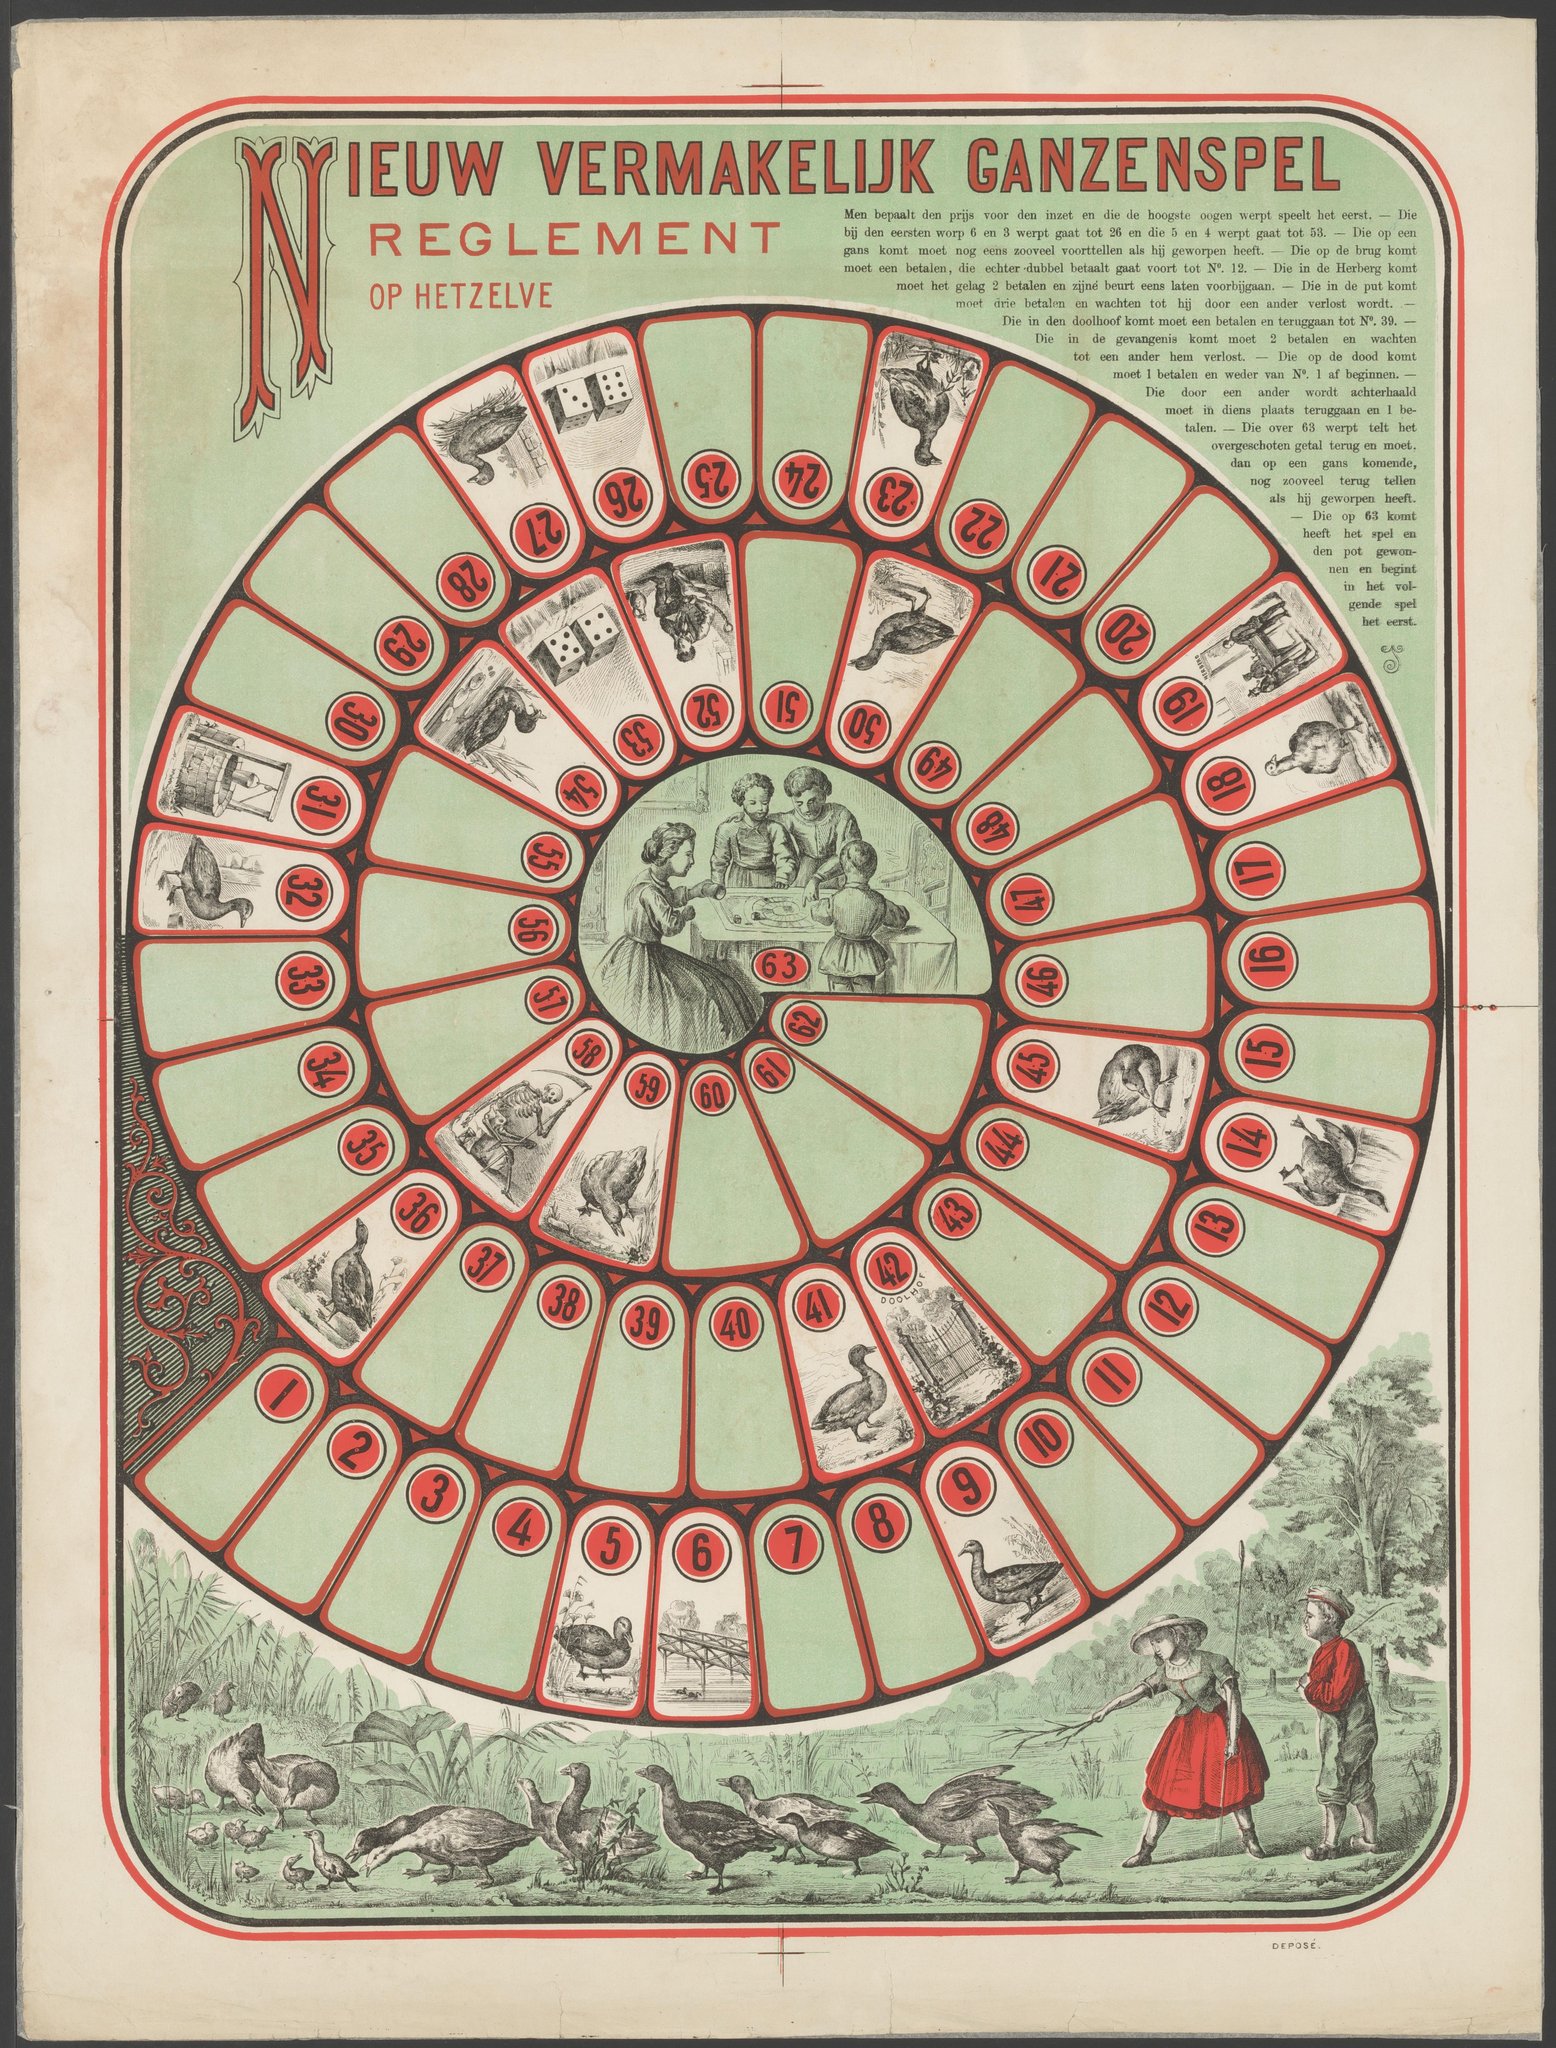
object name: print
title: Ganzenbordspel met ganzenhoedsters en een familie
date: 1880-1890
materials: paper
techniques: letterpress printing, lithograph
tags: goose-game, board-games of chance, board-games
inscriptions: : ‘Déposé’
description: Ganzenbordspel met 63 vakken in de vorm van een slakkenhuis. In het midden een vrouw die met drie kinderen een bordspel aan het spelen is. Rechtsboven de spelregels. Onder een troep ganzen met kuikens die door een jongen en een meisje worden gehoed. Onderwerpsrubrieken binnen de Atlas Zeden en Gewoonten: Zeden en gewoonten in engeren zin, Spel en vermaak, Gezelschapsspel II, Ganzenbord en dergelijke.